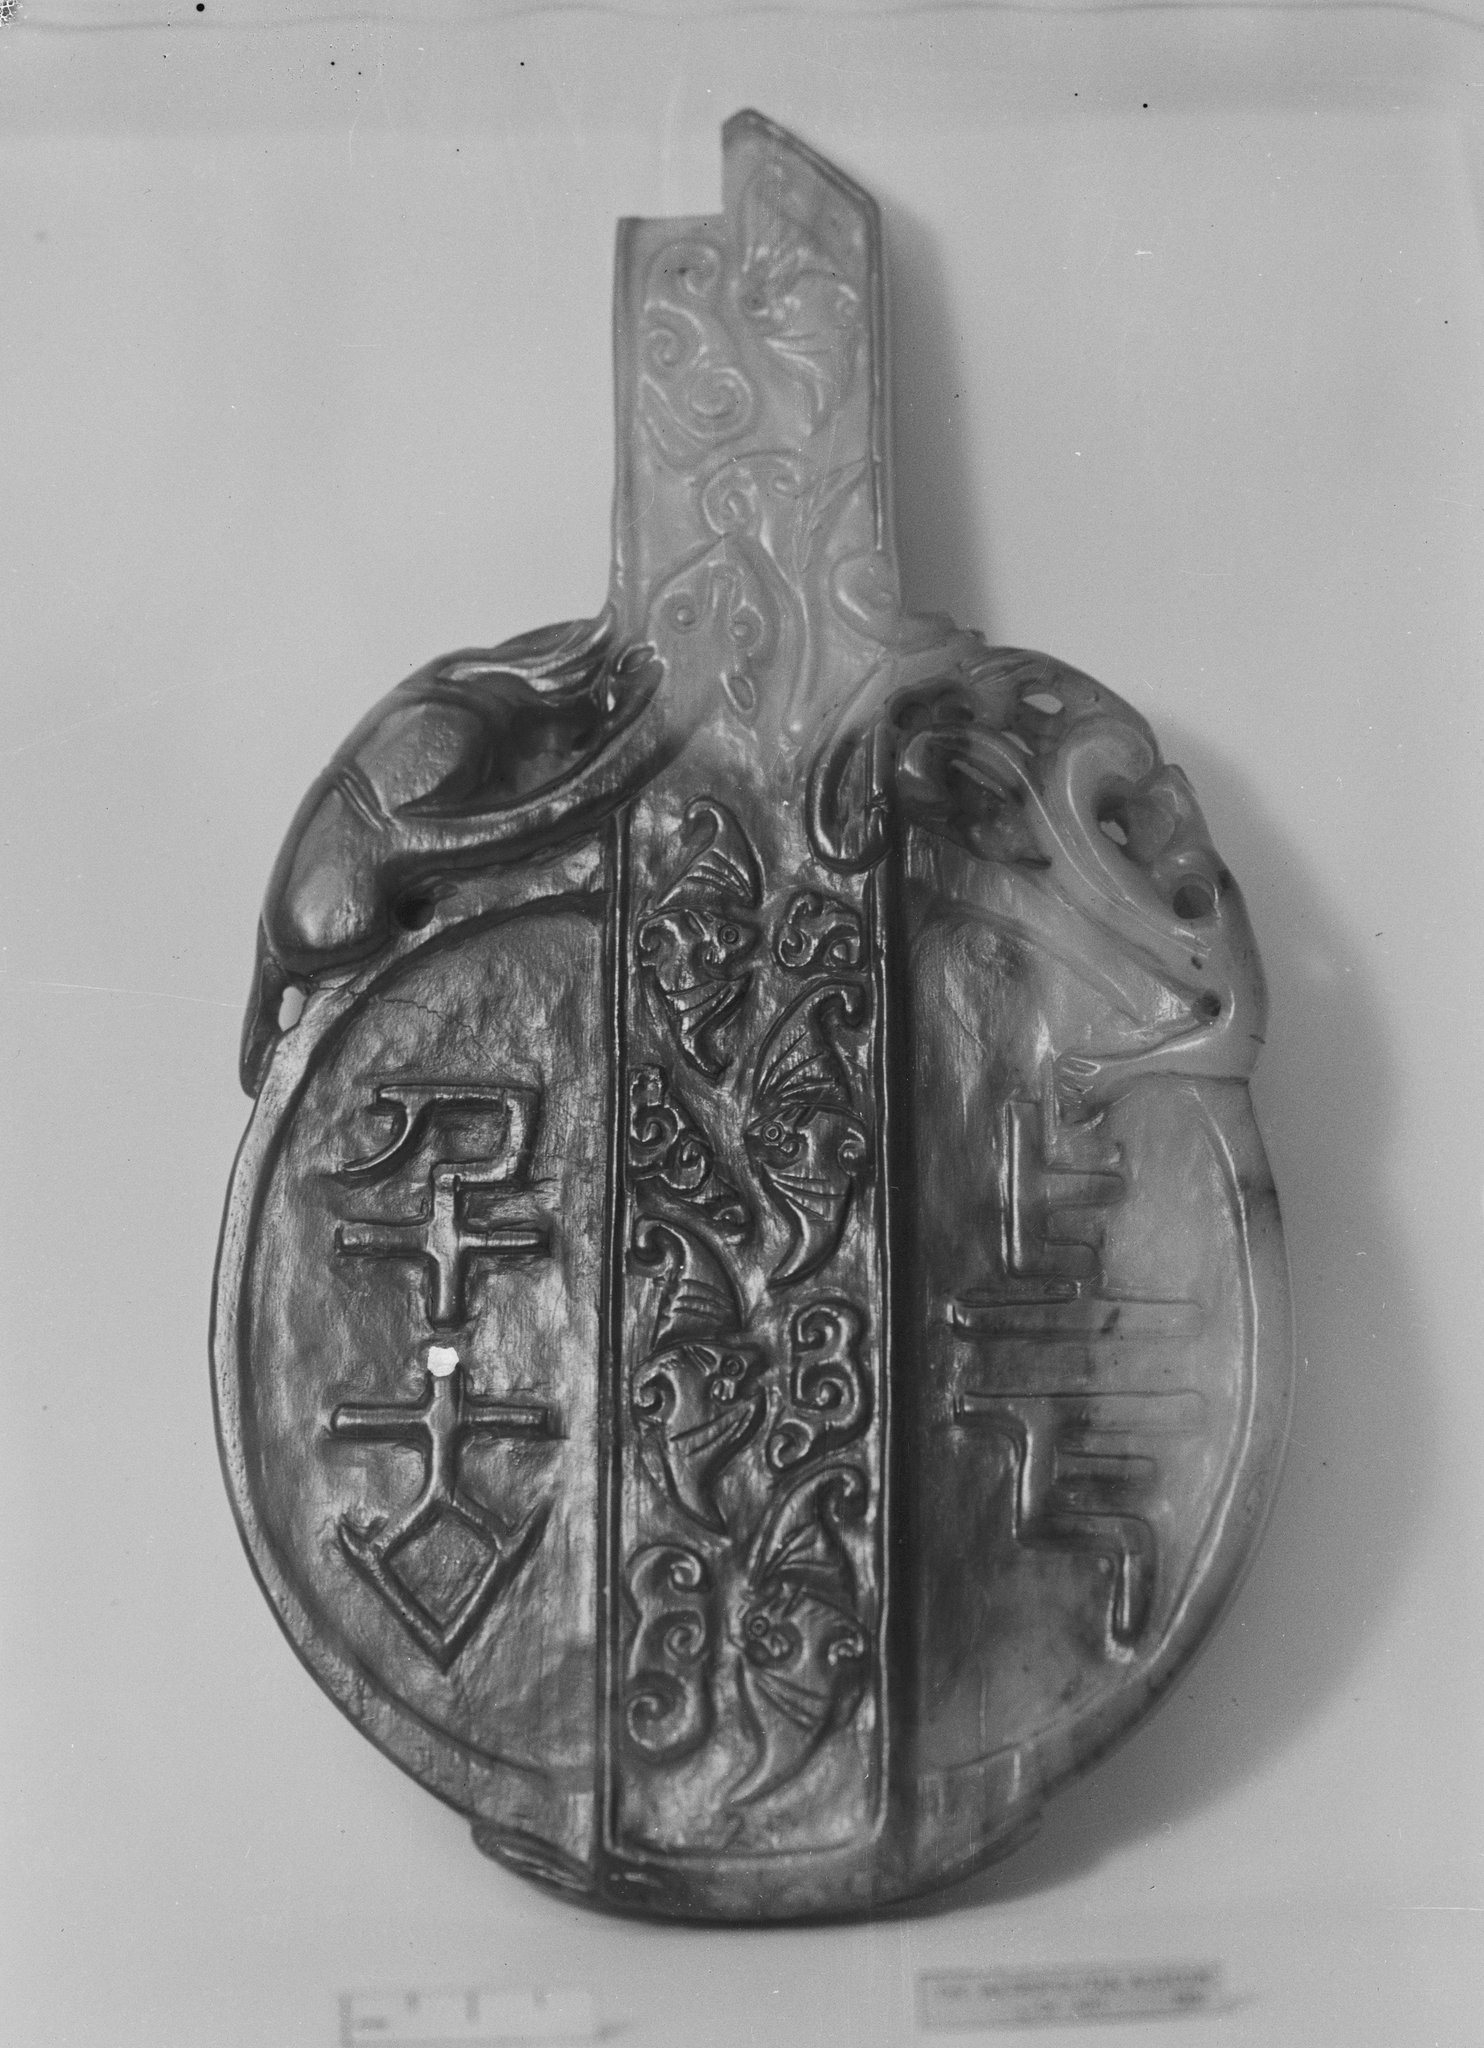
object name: tablet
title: Sacrificial Tablet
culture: chinese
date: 1644-1912